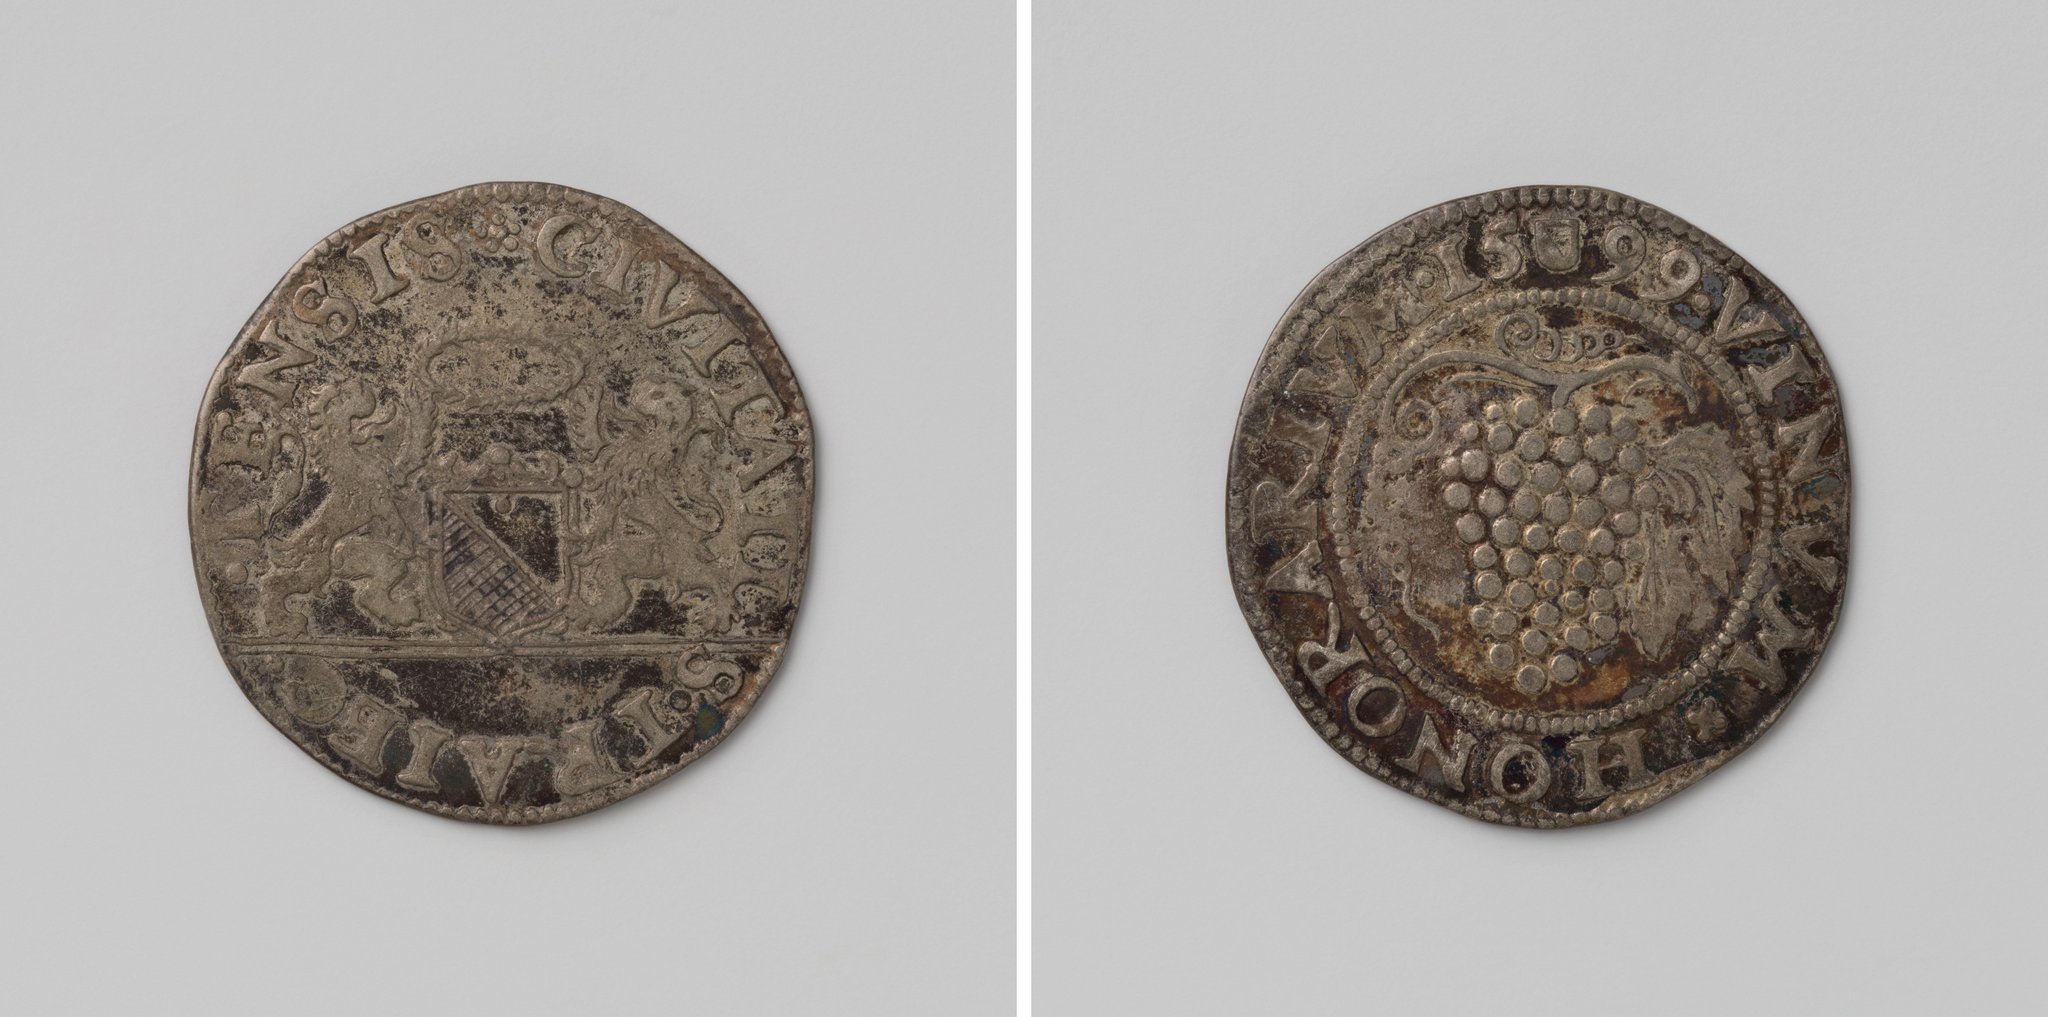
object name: marksman medal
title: Schutterij van Utrecht, penning die schutters recht gaf op een kan wijn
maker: Anonymous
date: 1599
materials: silver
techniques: striking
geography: utrecht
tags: utrecht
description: Zilveren wijn- en schutterspenning van Utrecht. Voorzijde: wapenschild, waarboven twee leeuwen lauwerkrans houden binnen omschrift. Keerzijde: tros druiven binnen omschrift